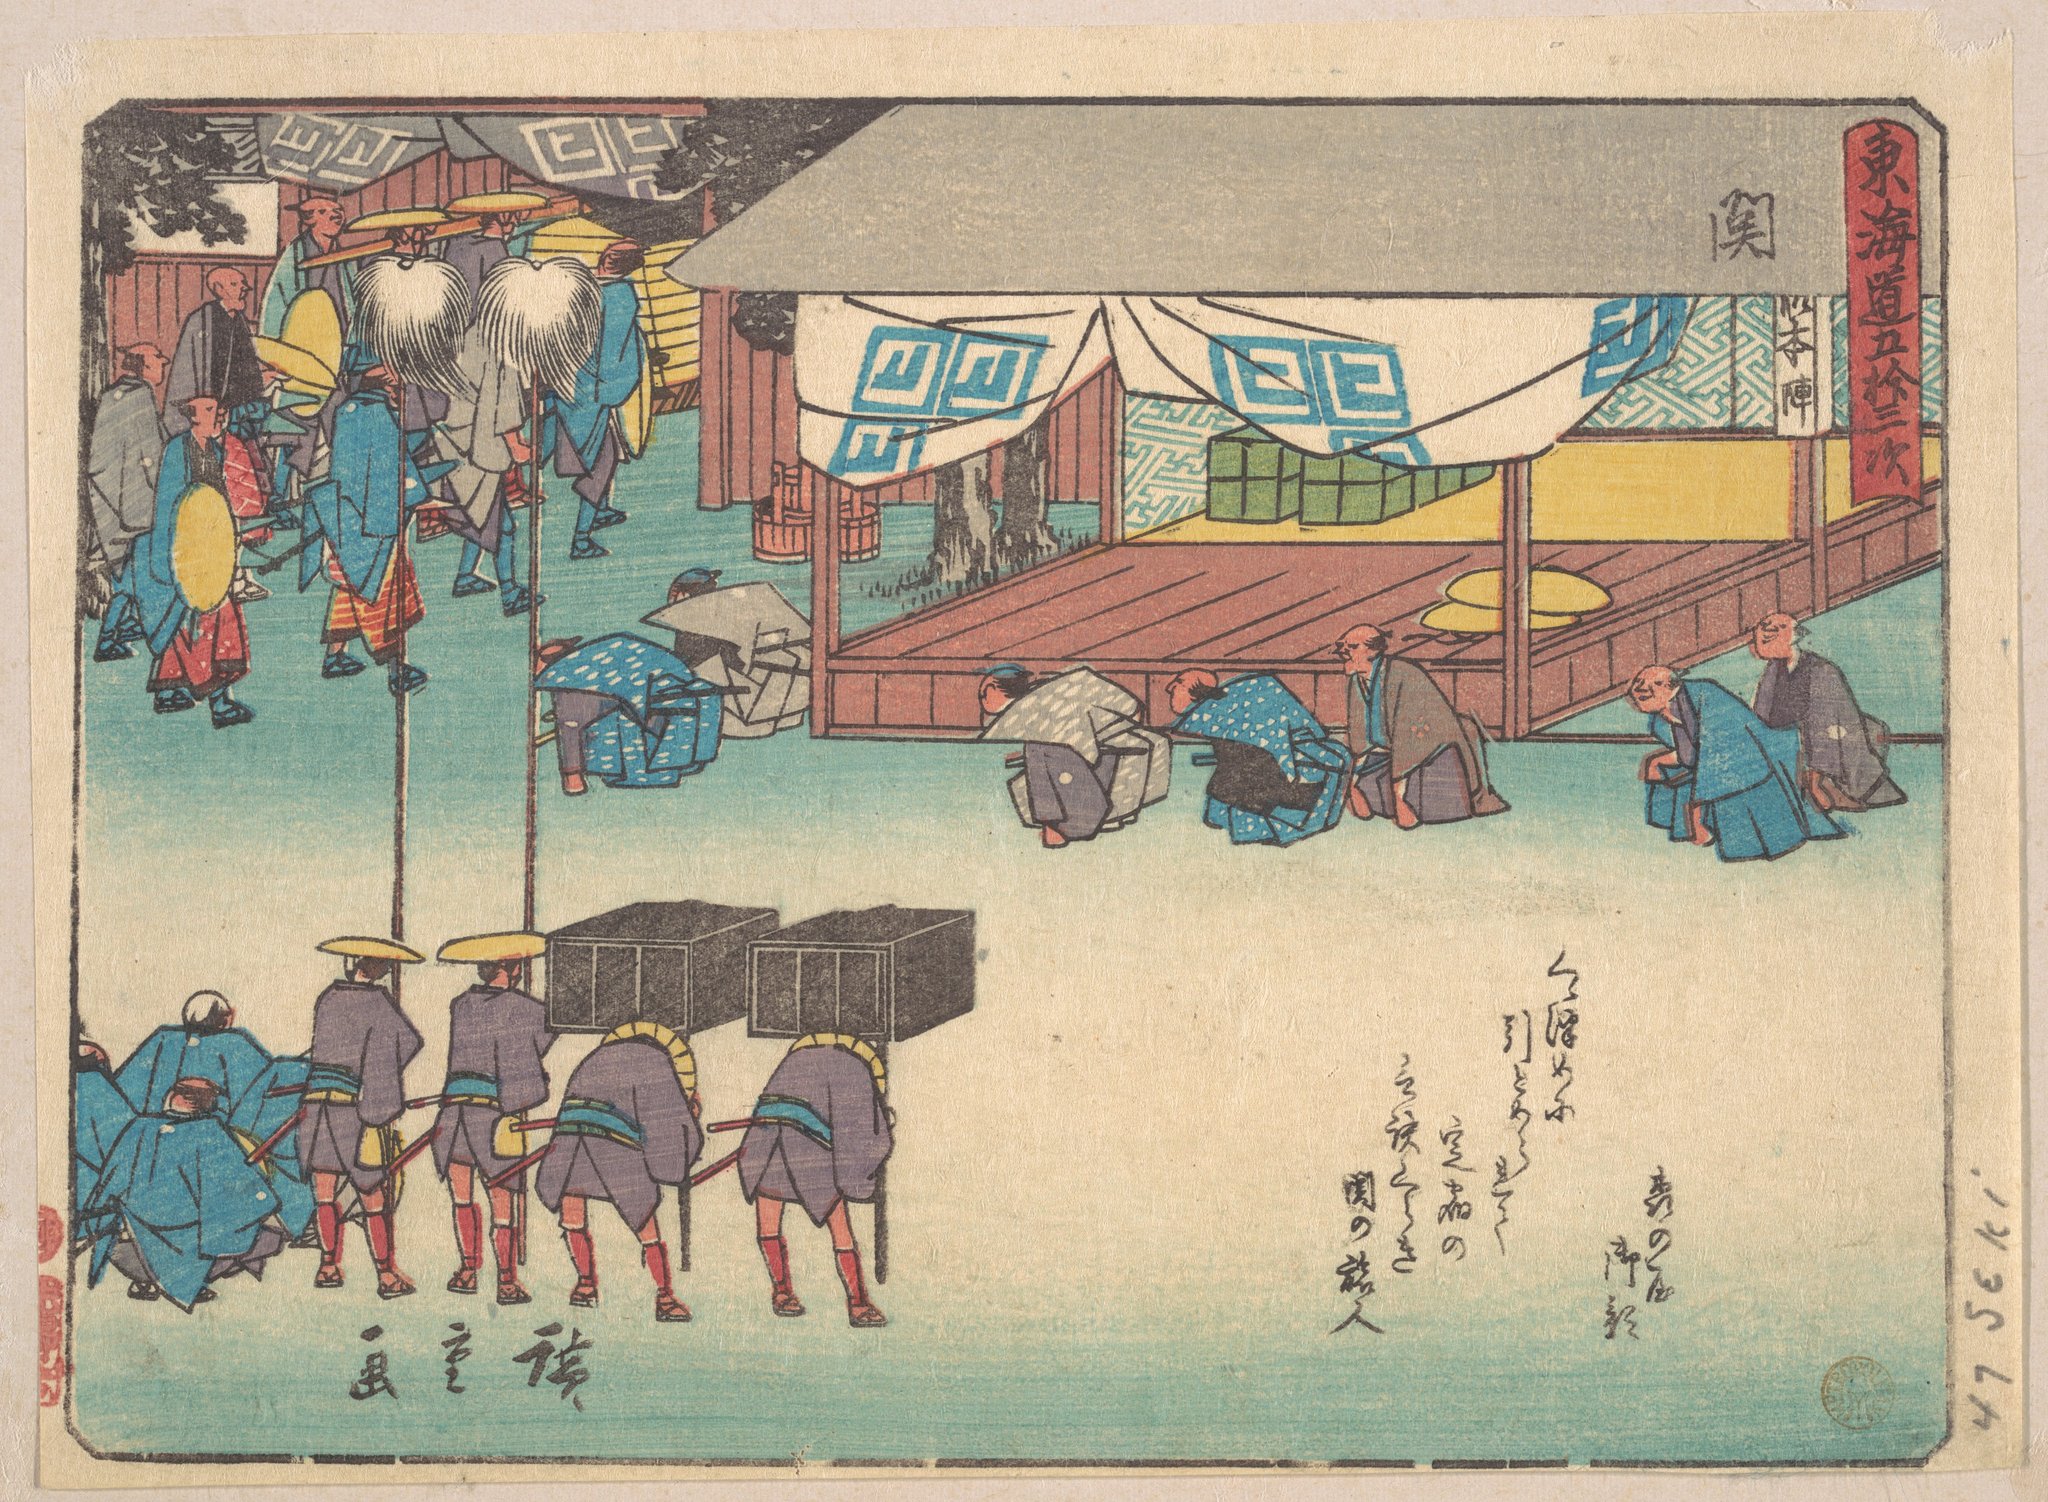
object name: print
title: Seki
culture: japanese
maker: utagawa hiroshige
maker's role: artist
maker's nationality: japanese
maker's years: 1797-1858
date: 1838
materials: ink, paper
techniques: woodblock print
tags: men